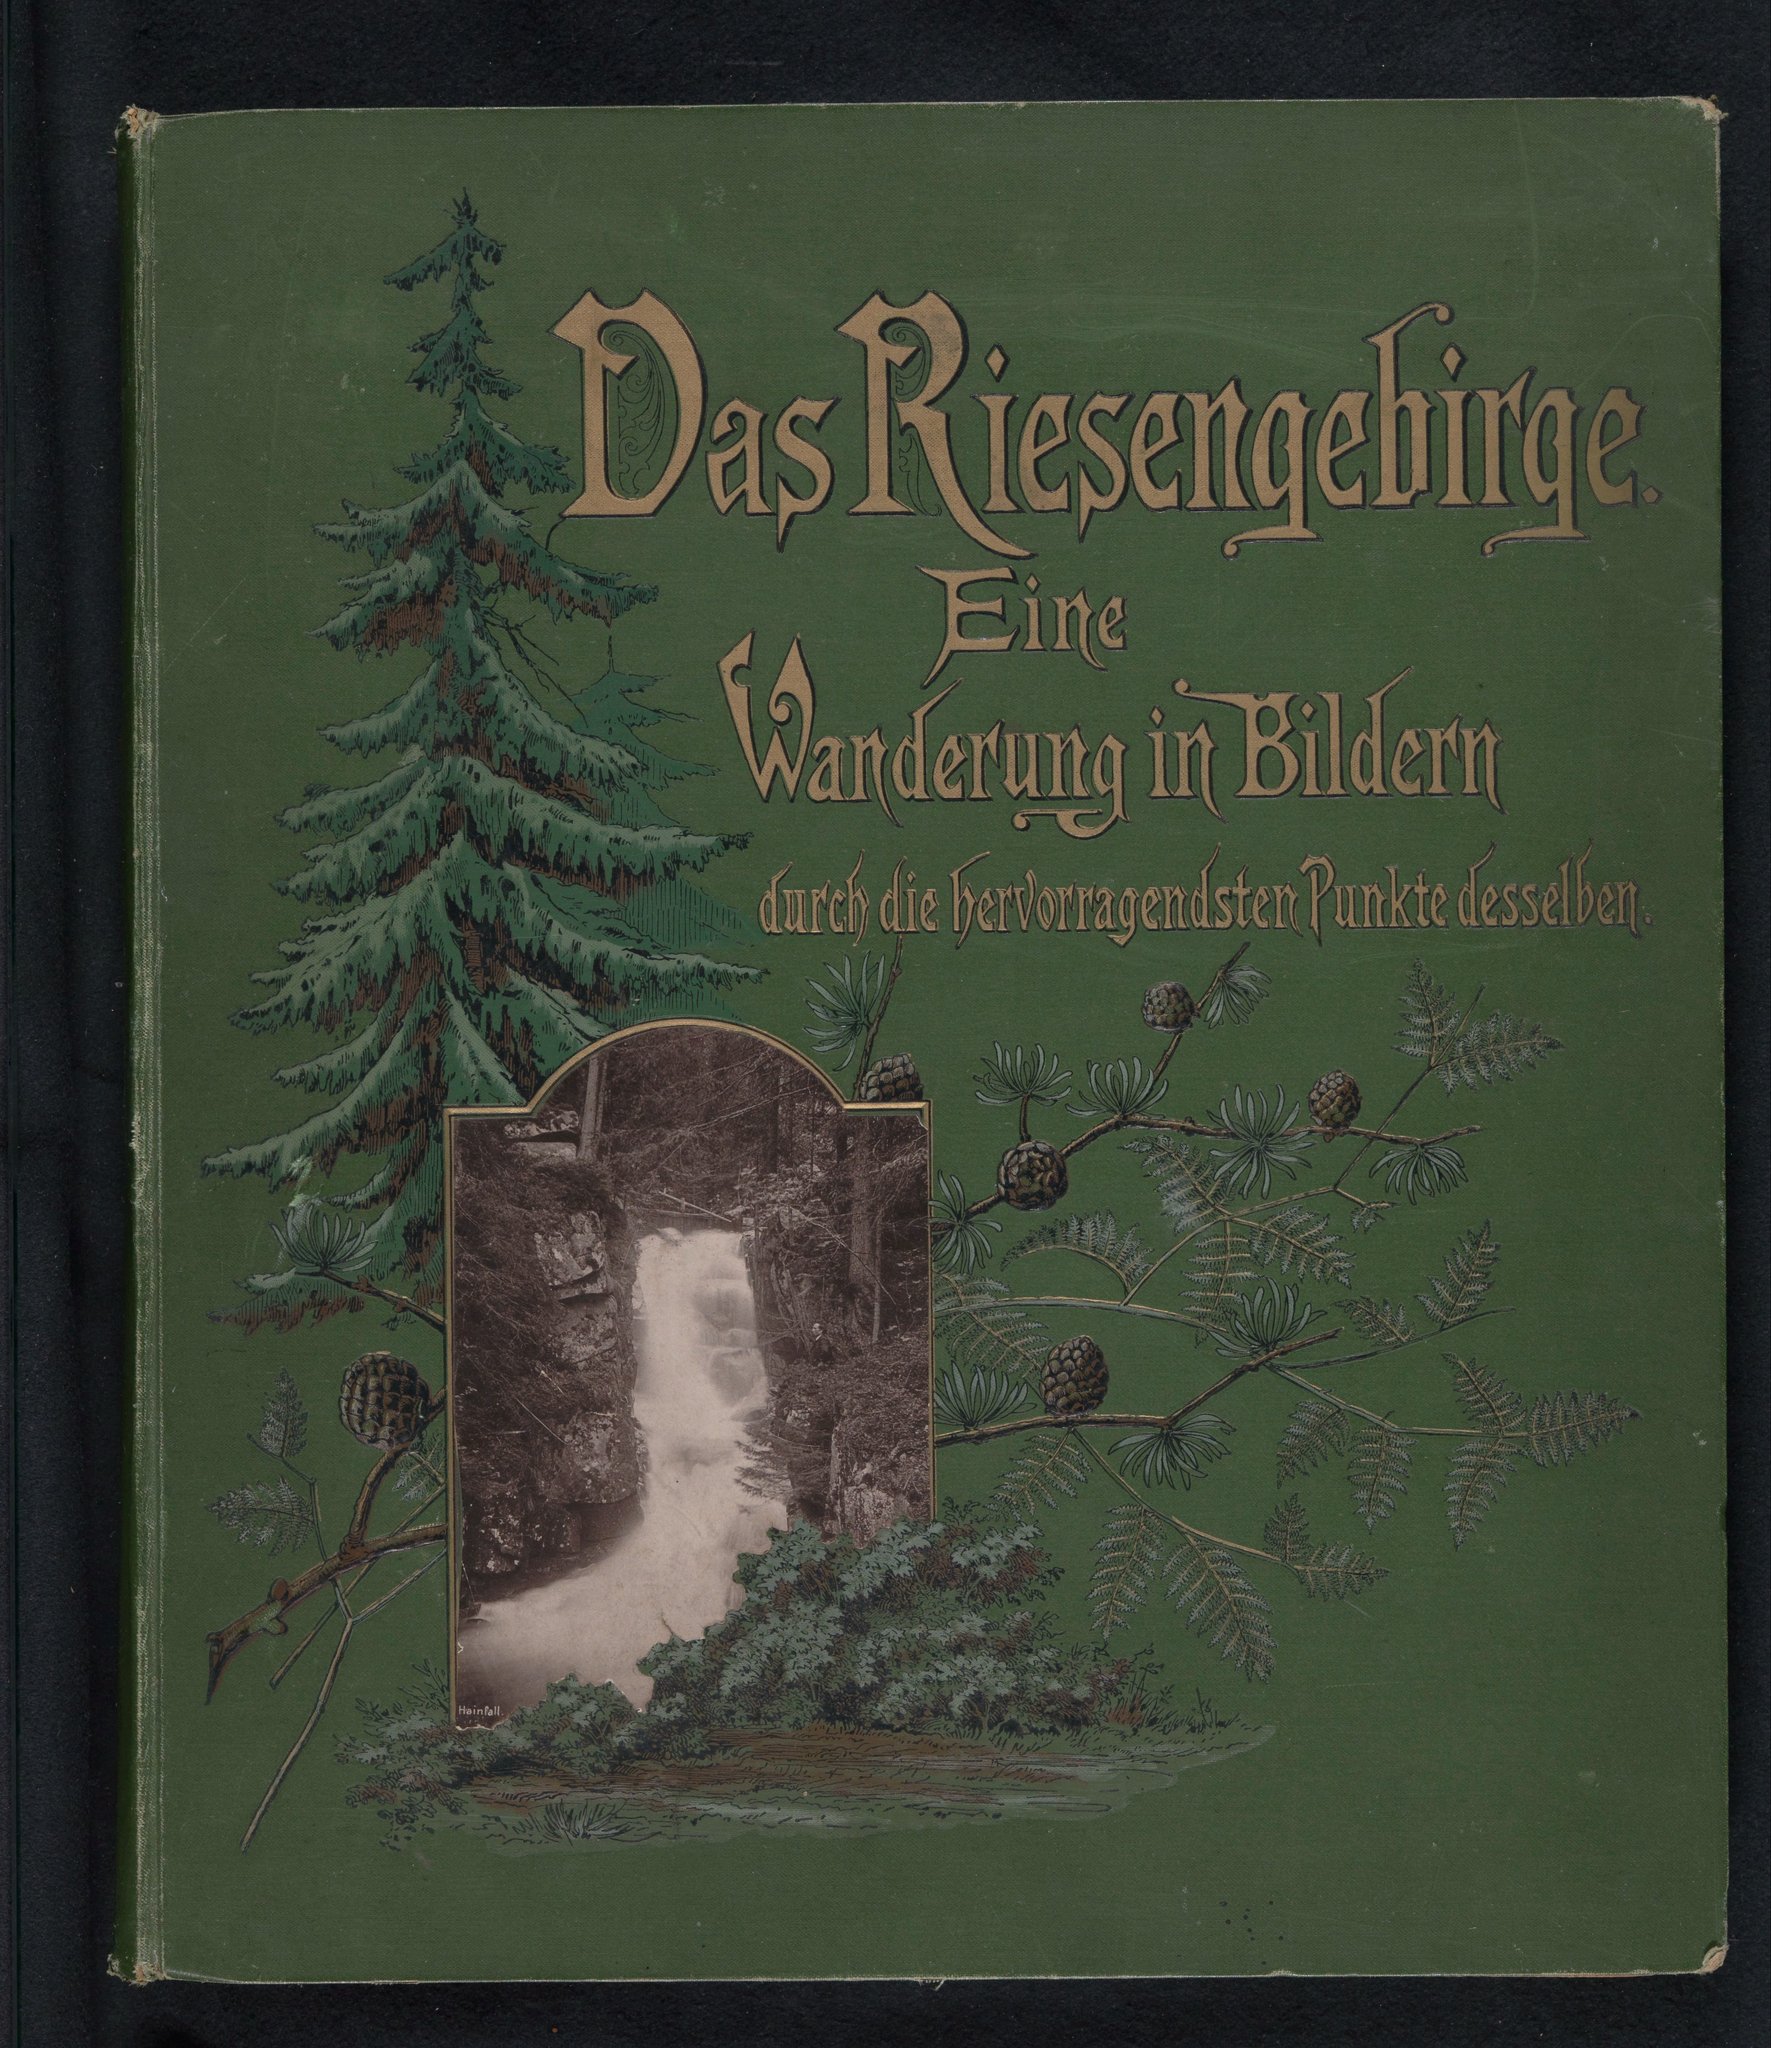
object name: page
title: Hainfall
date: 1887-1892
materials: paper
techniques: photograph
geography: reuzengebergte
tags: waterfall